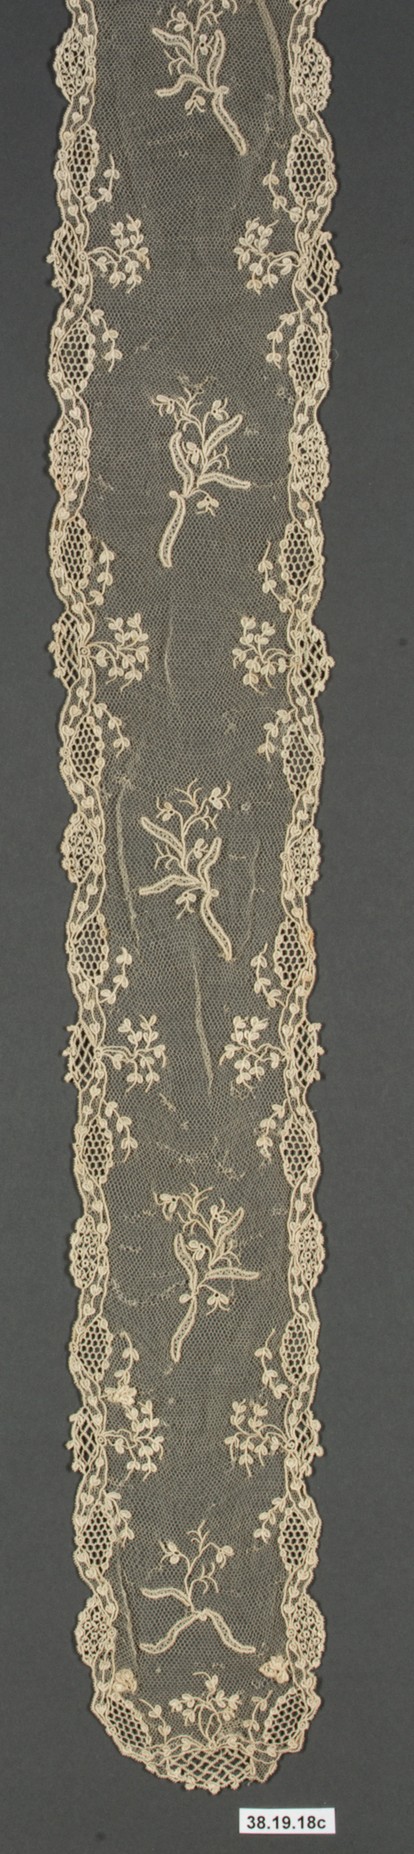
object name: lappet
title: Pair of lappets (part of a garniture)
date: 1774-1793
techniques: lace